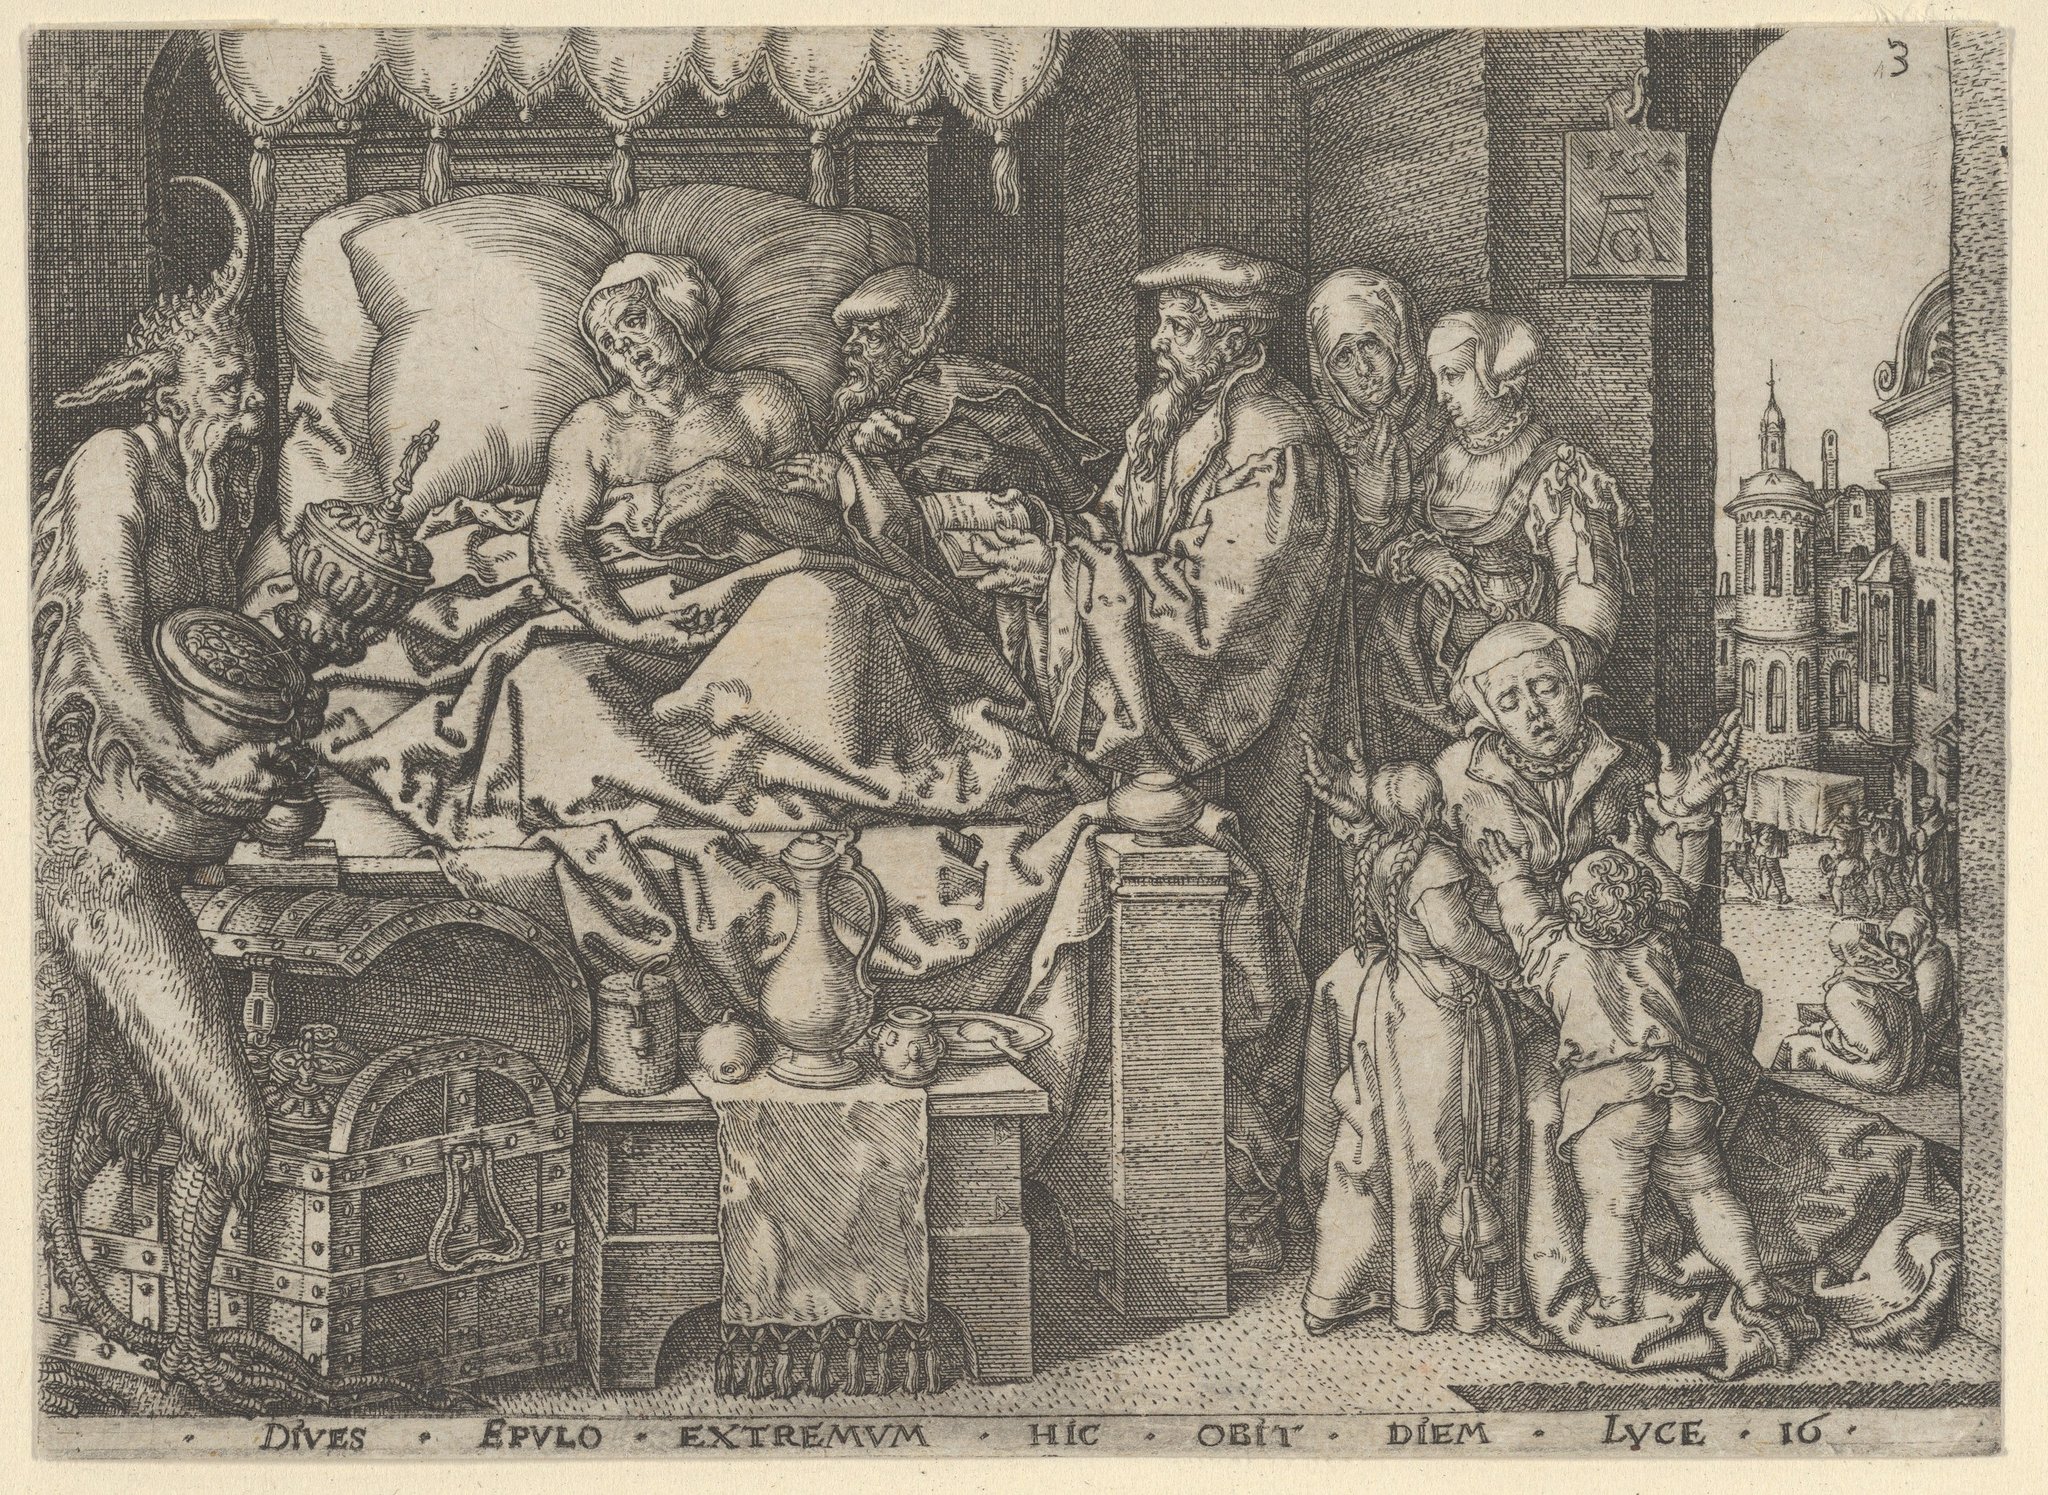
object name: print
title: The Rich Man on His Deathbed, from "The Parable of the Rich Man and Lazarus"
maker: heinrich aldegrever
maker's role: artist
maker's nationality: german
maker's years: 1502-1561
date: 1554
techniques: engraving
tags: bedrooms,sadness,men,women,mythical creatures,devil,death